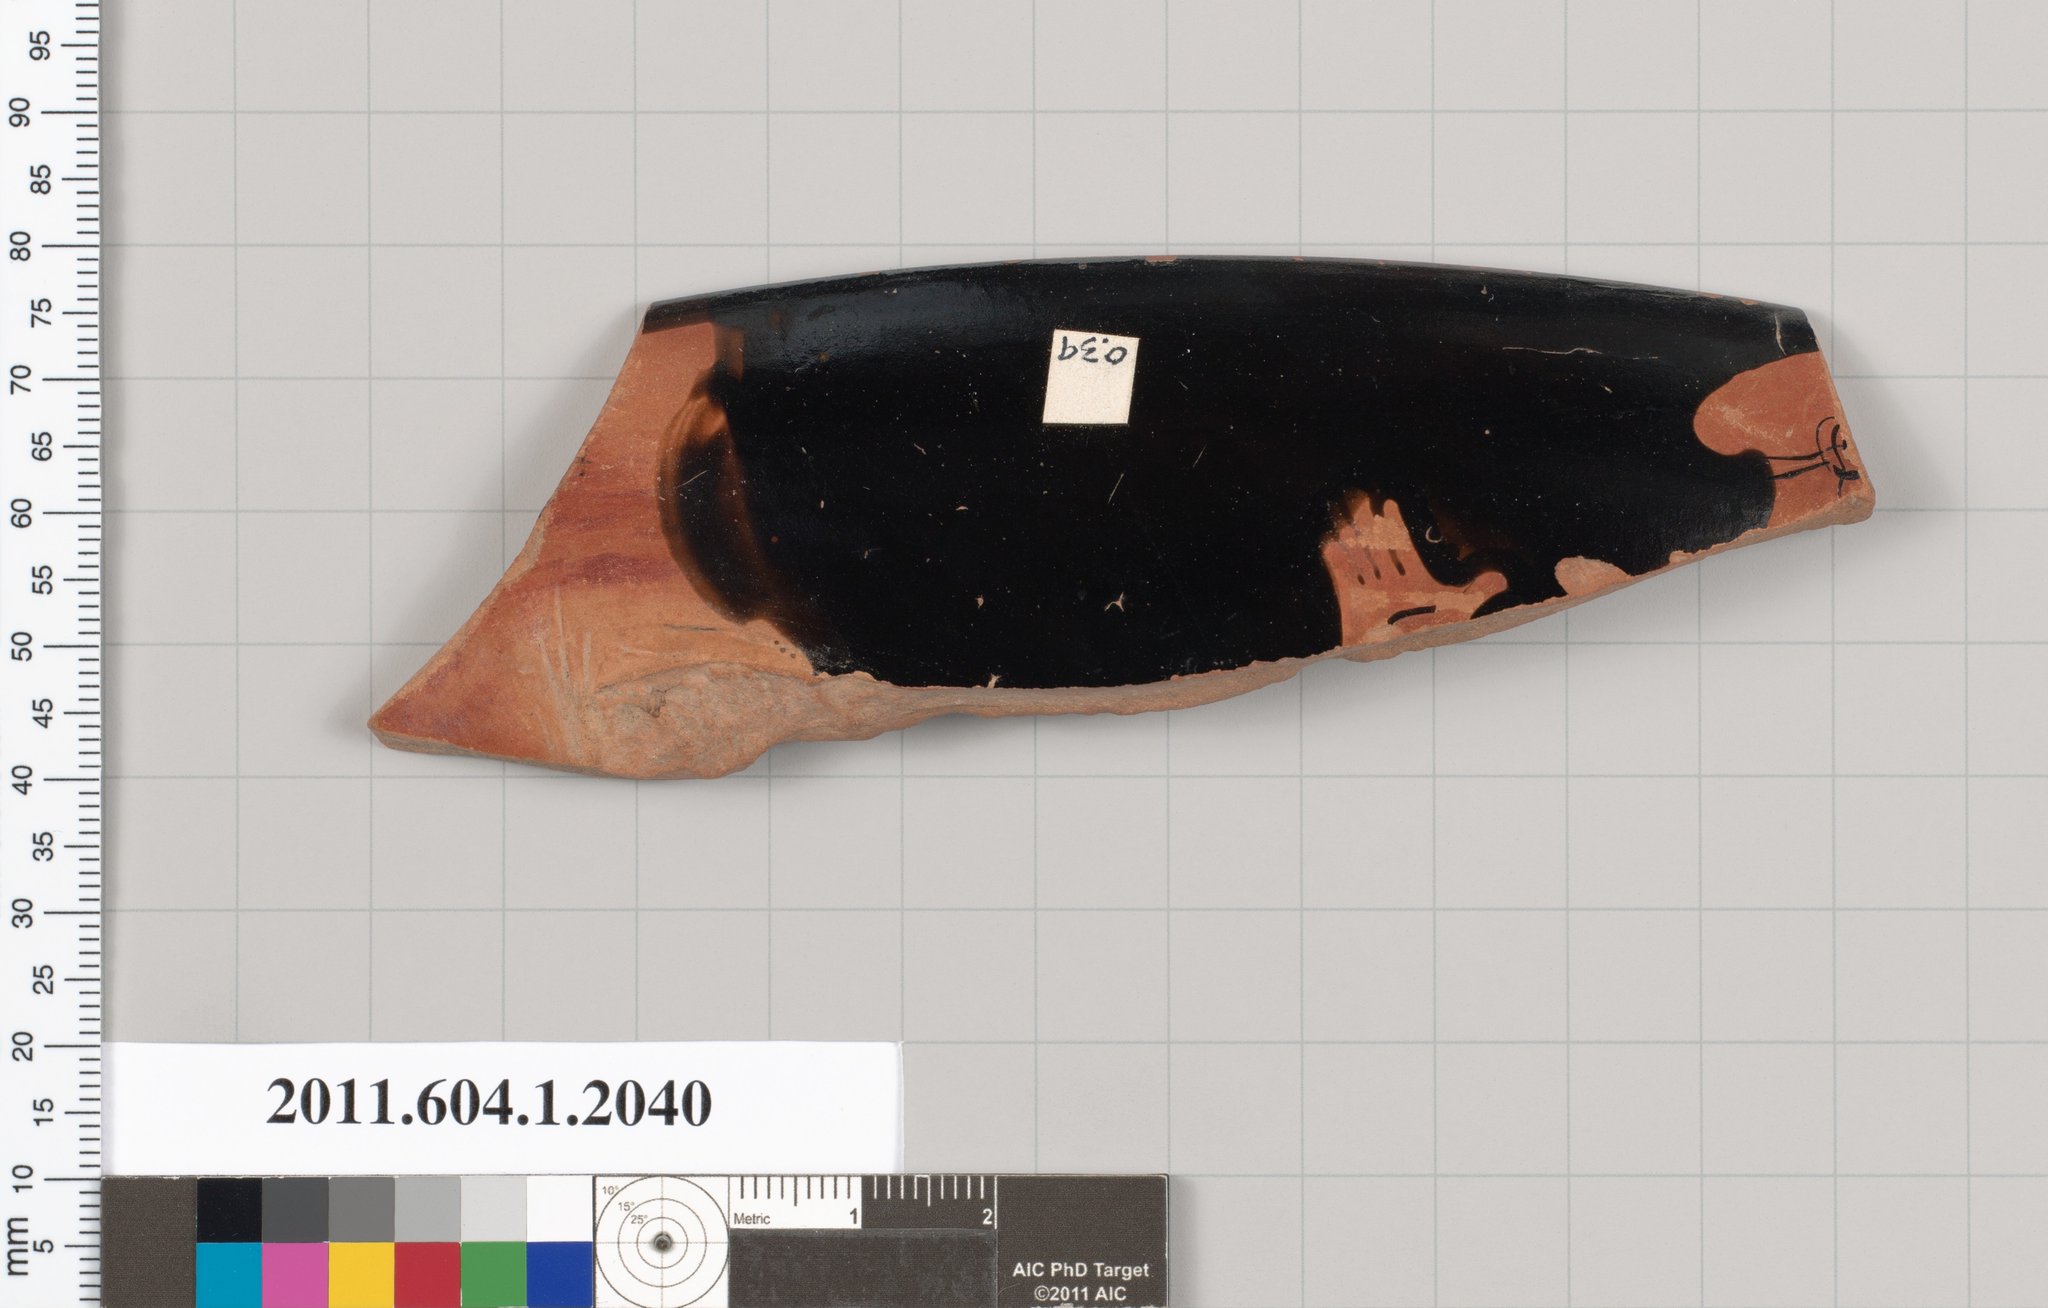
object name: kylix fragment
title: Terracotta rim fragment of a kylix (drinking cup)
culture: greek, attic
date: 467-435 BCE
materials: terracotta